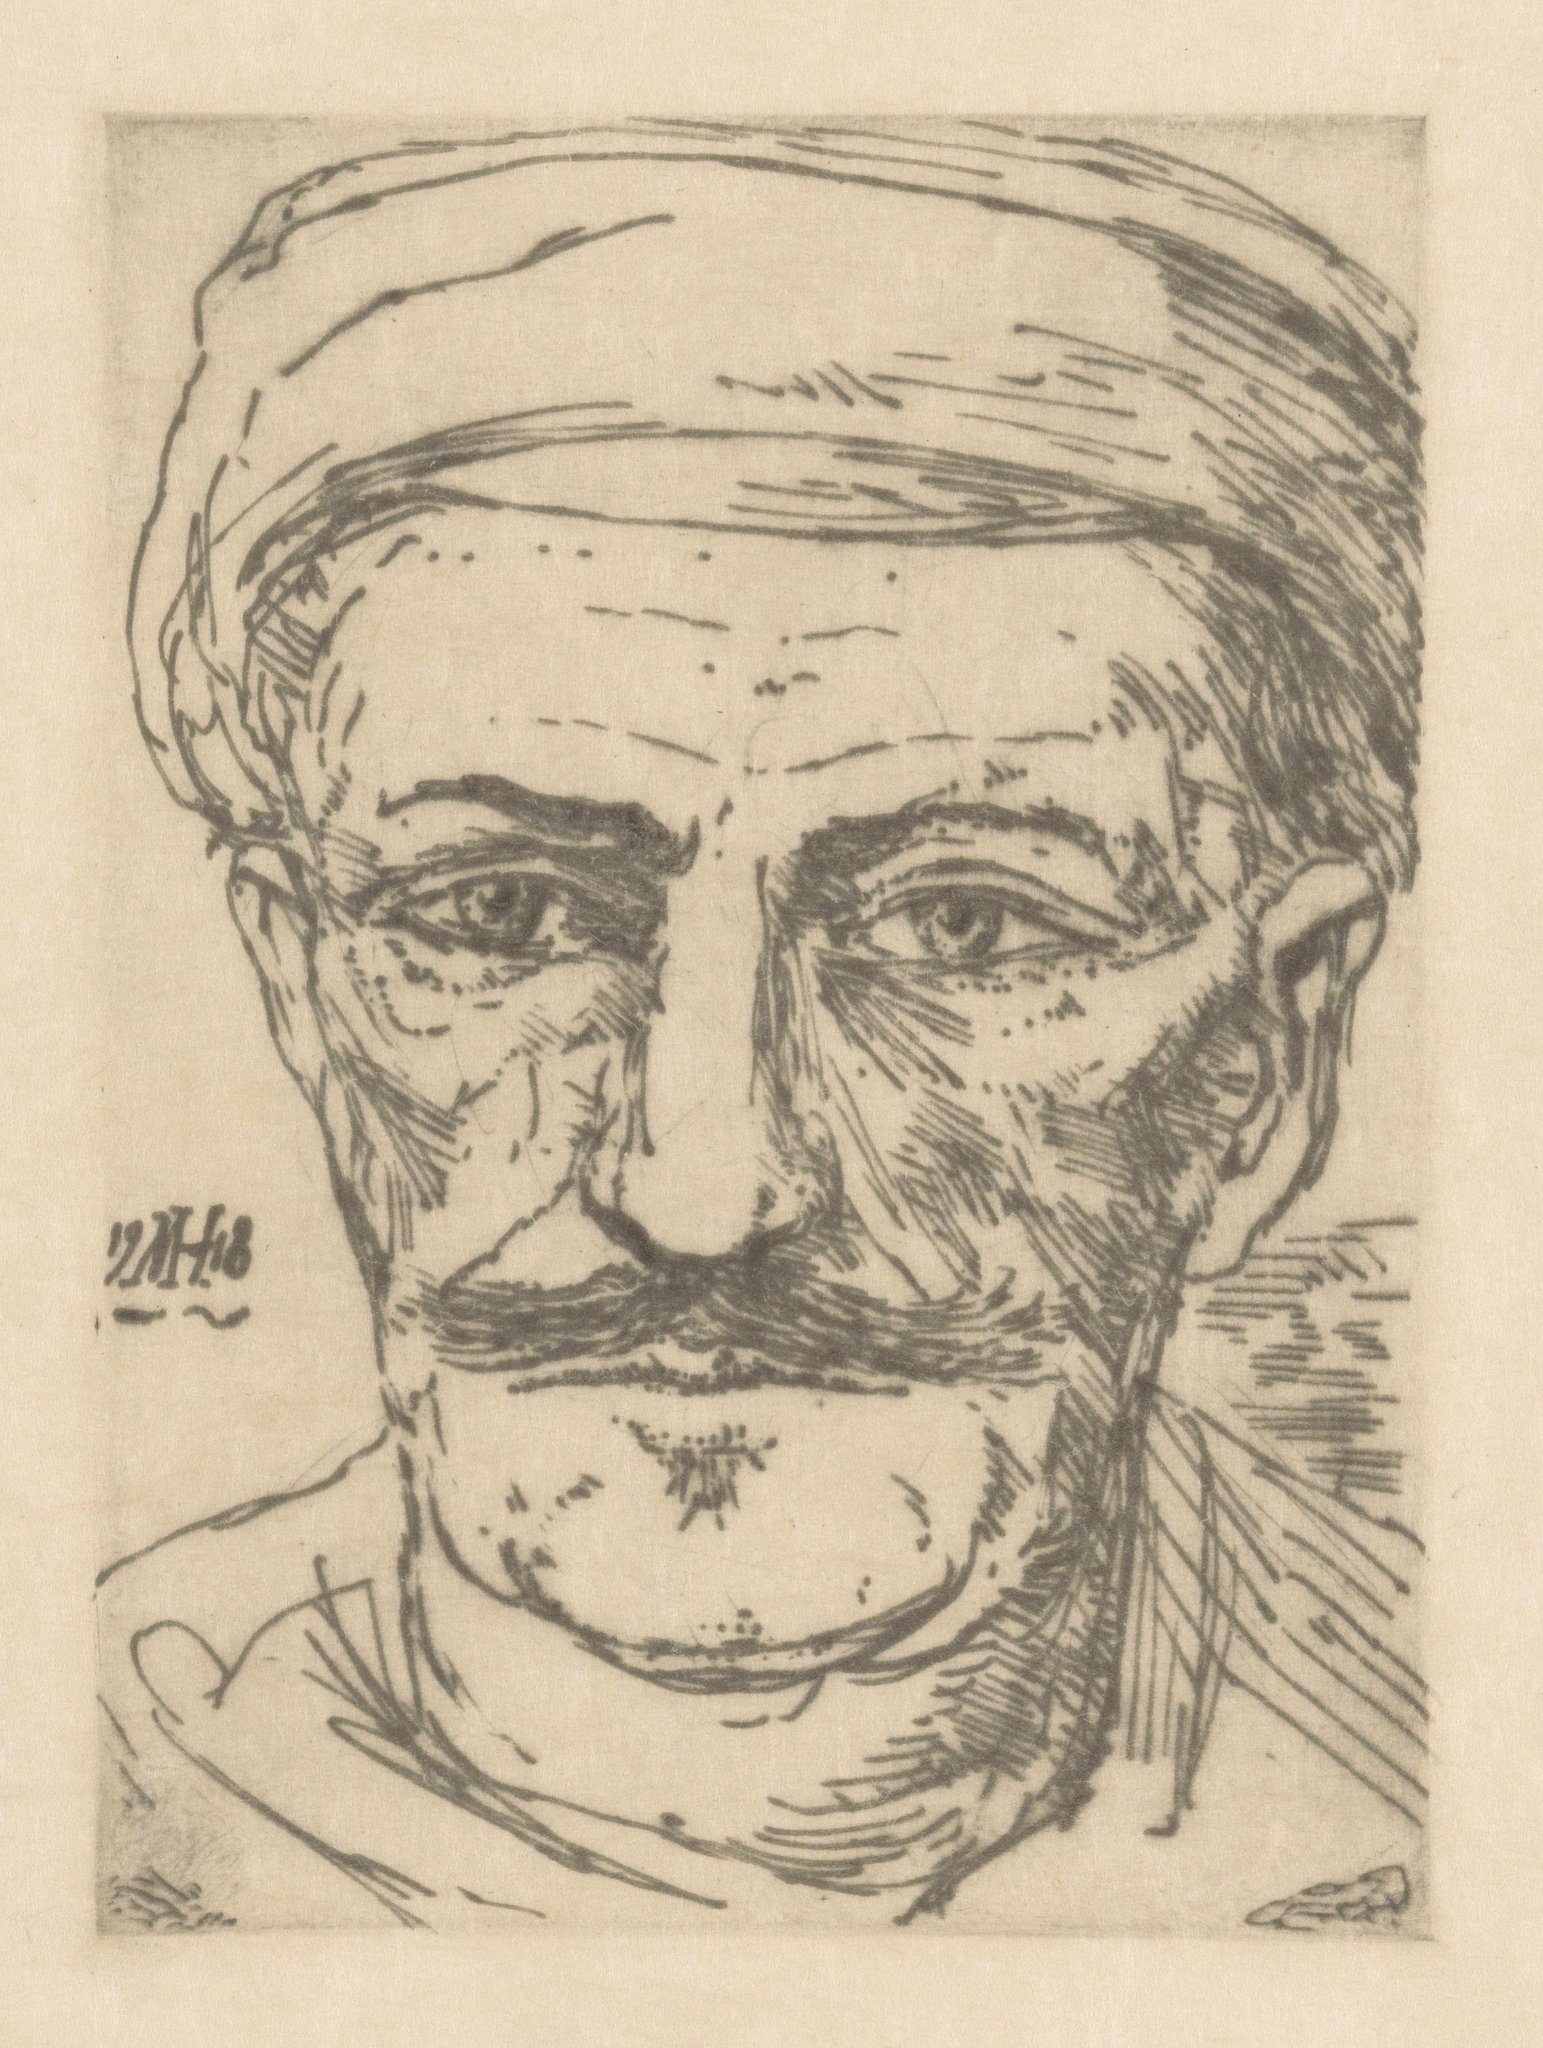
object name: print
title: Oude man met snor en muts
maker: marius holleman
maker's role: draughtsman, print maker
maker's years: 1878-1926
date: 1918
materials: paper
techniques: printmaking, etching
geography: groningen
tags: moustache, head-gear: hat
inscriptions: collector's mark: Lugt 2228